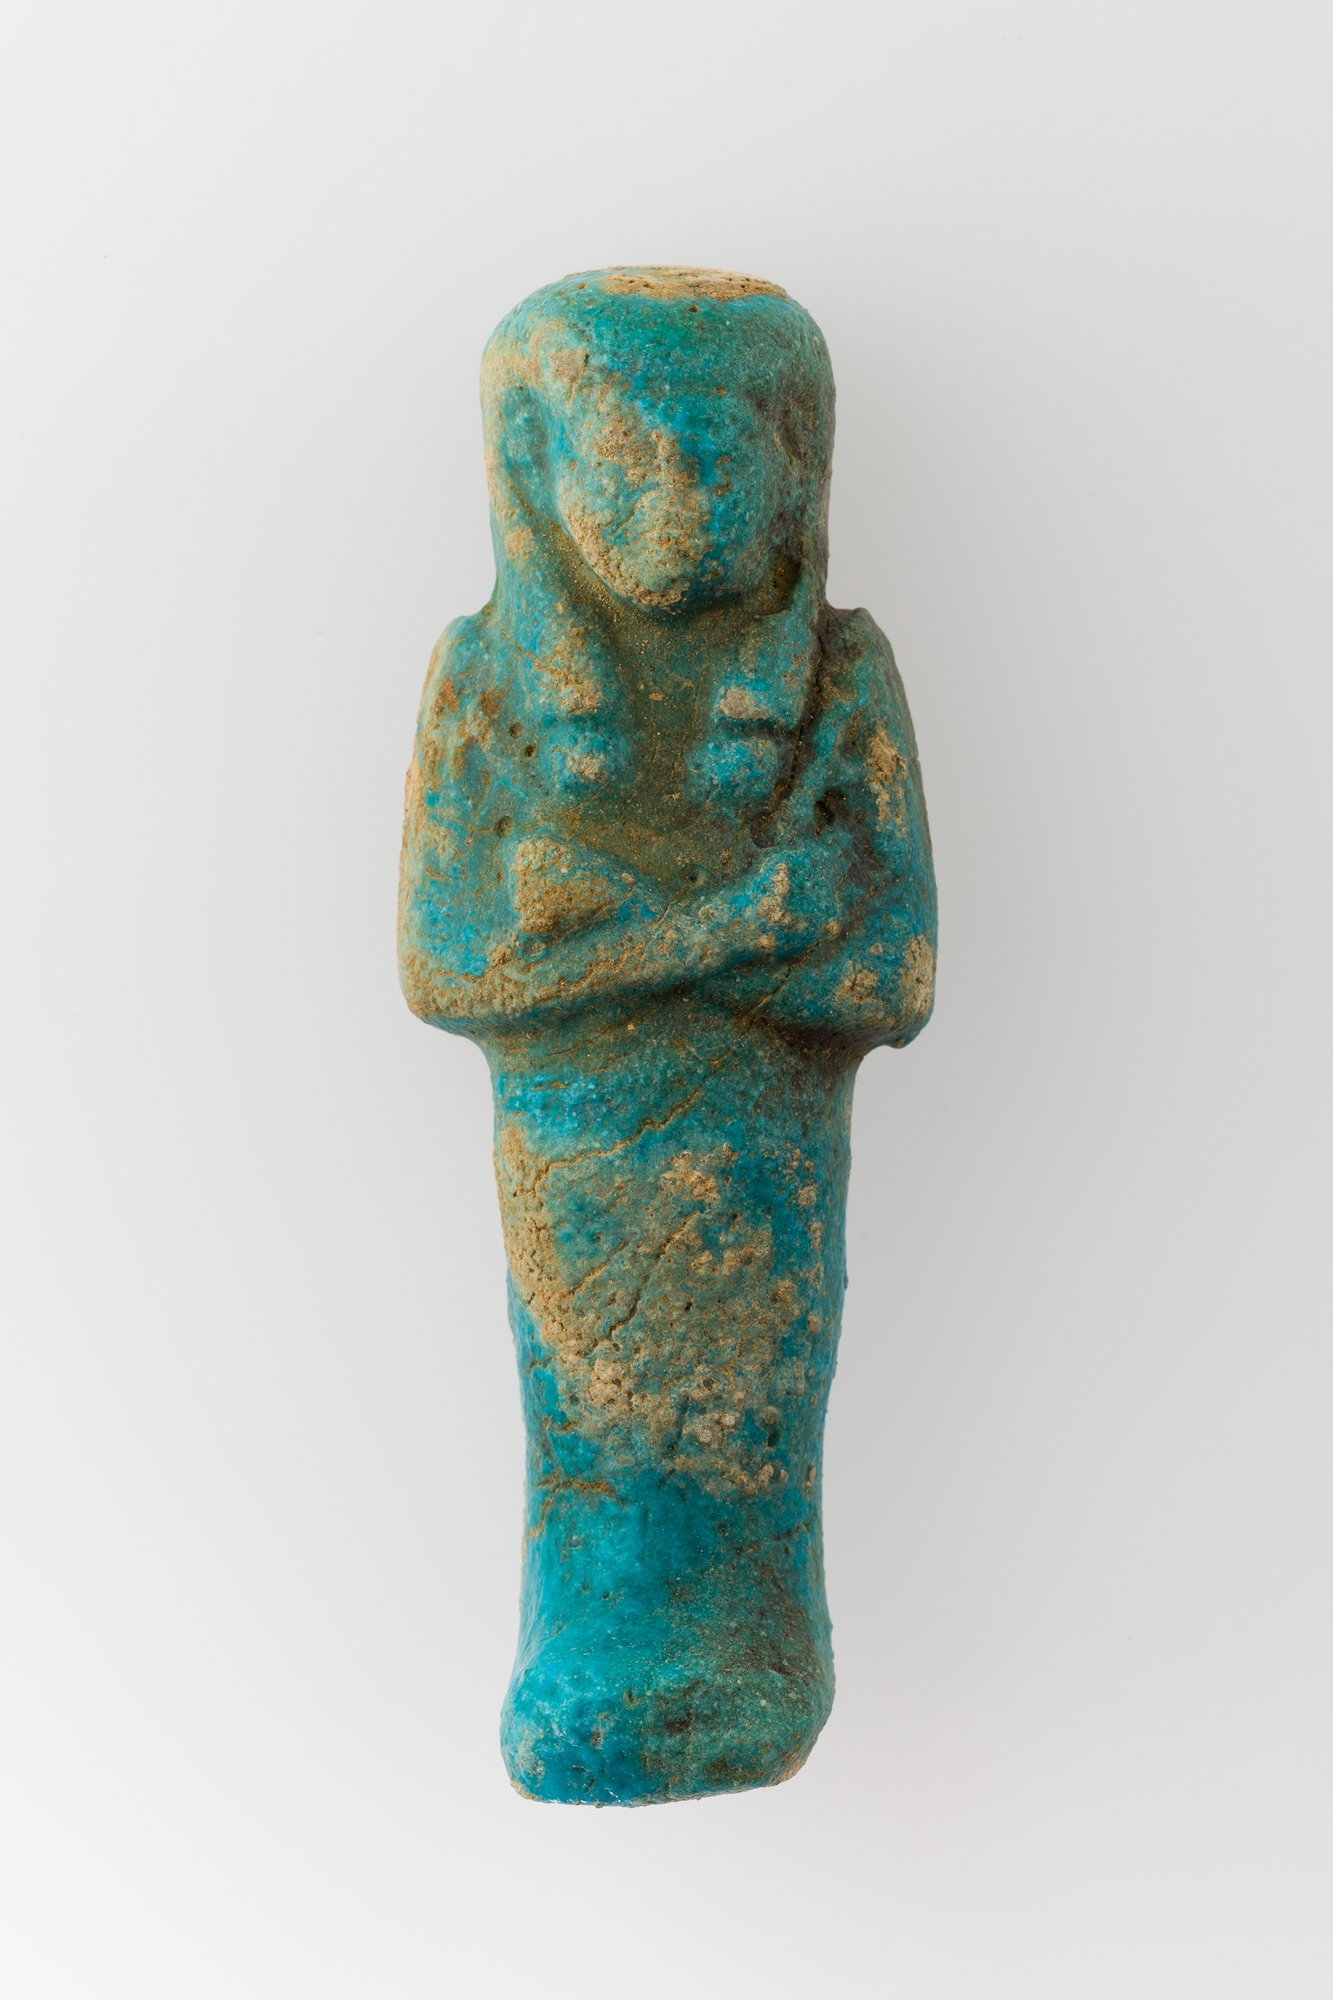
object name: shabti, henettawy c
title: Worker Shabti of Henettawy (C), Daughter of Isetemkheb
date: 990-970 BCE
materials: faience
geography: egypt